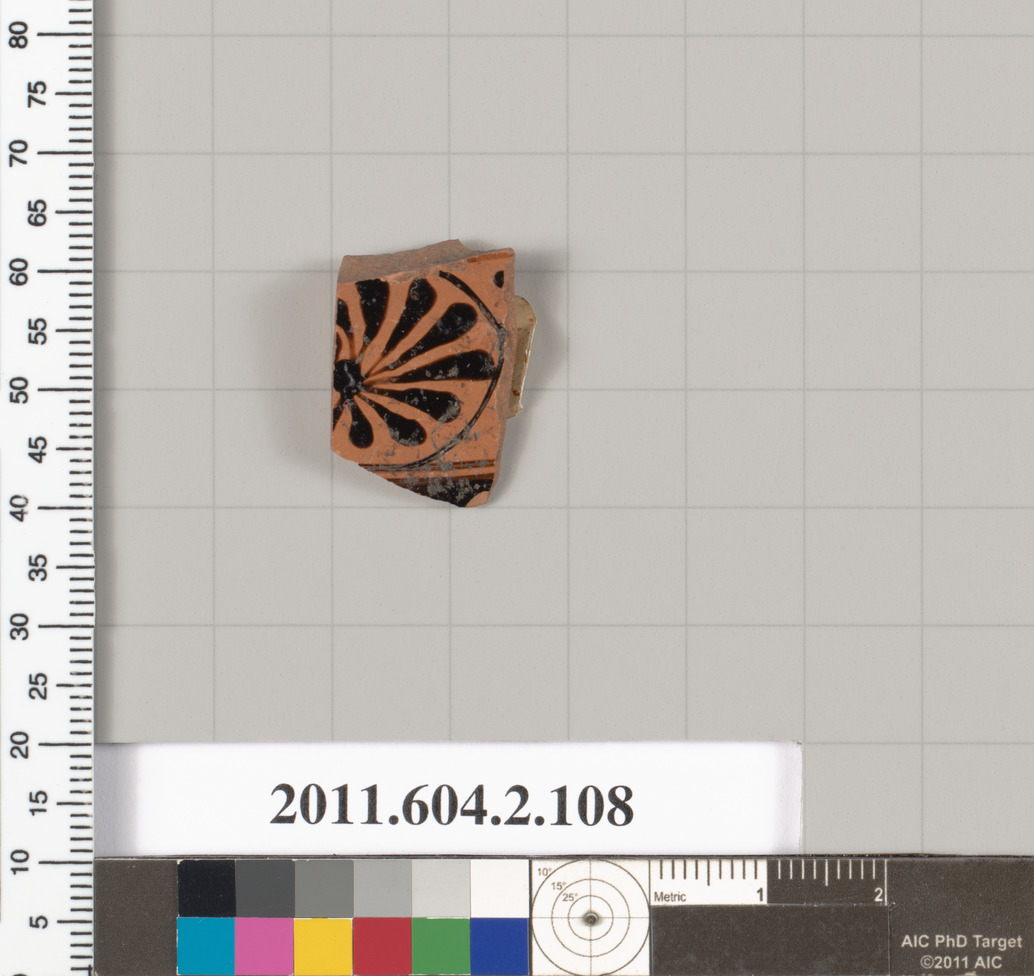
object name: pelike fragment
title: Terracotta fragment of a pelike (jar)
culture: greek, attic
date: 520-510 BCE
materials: terracotta